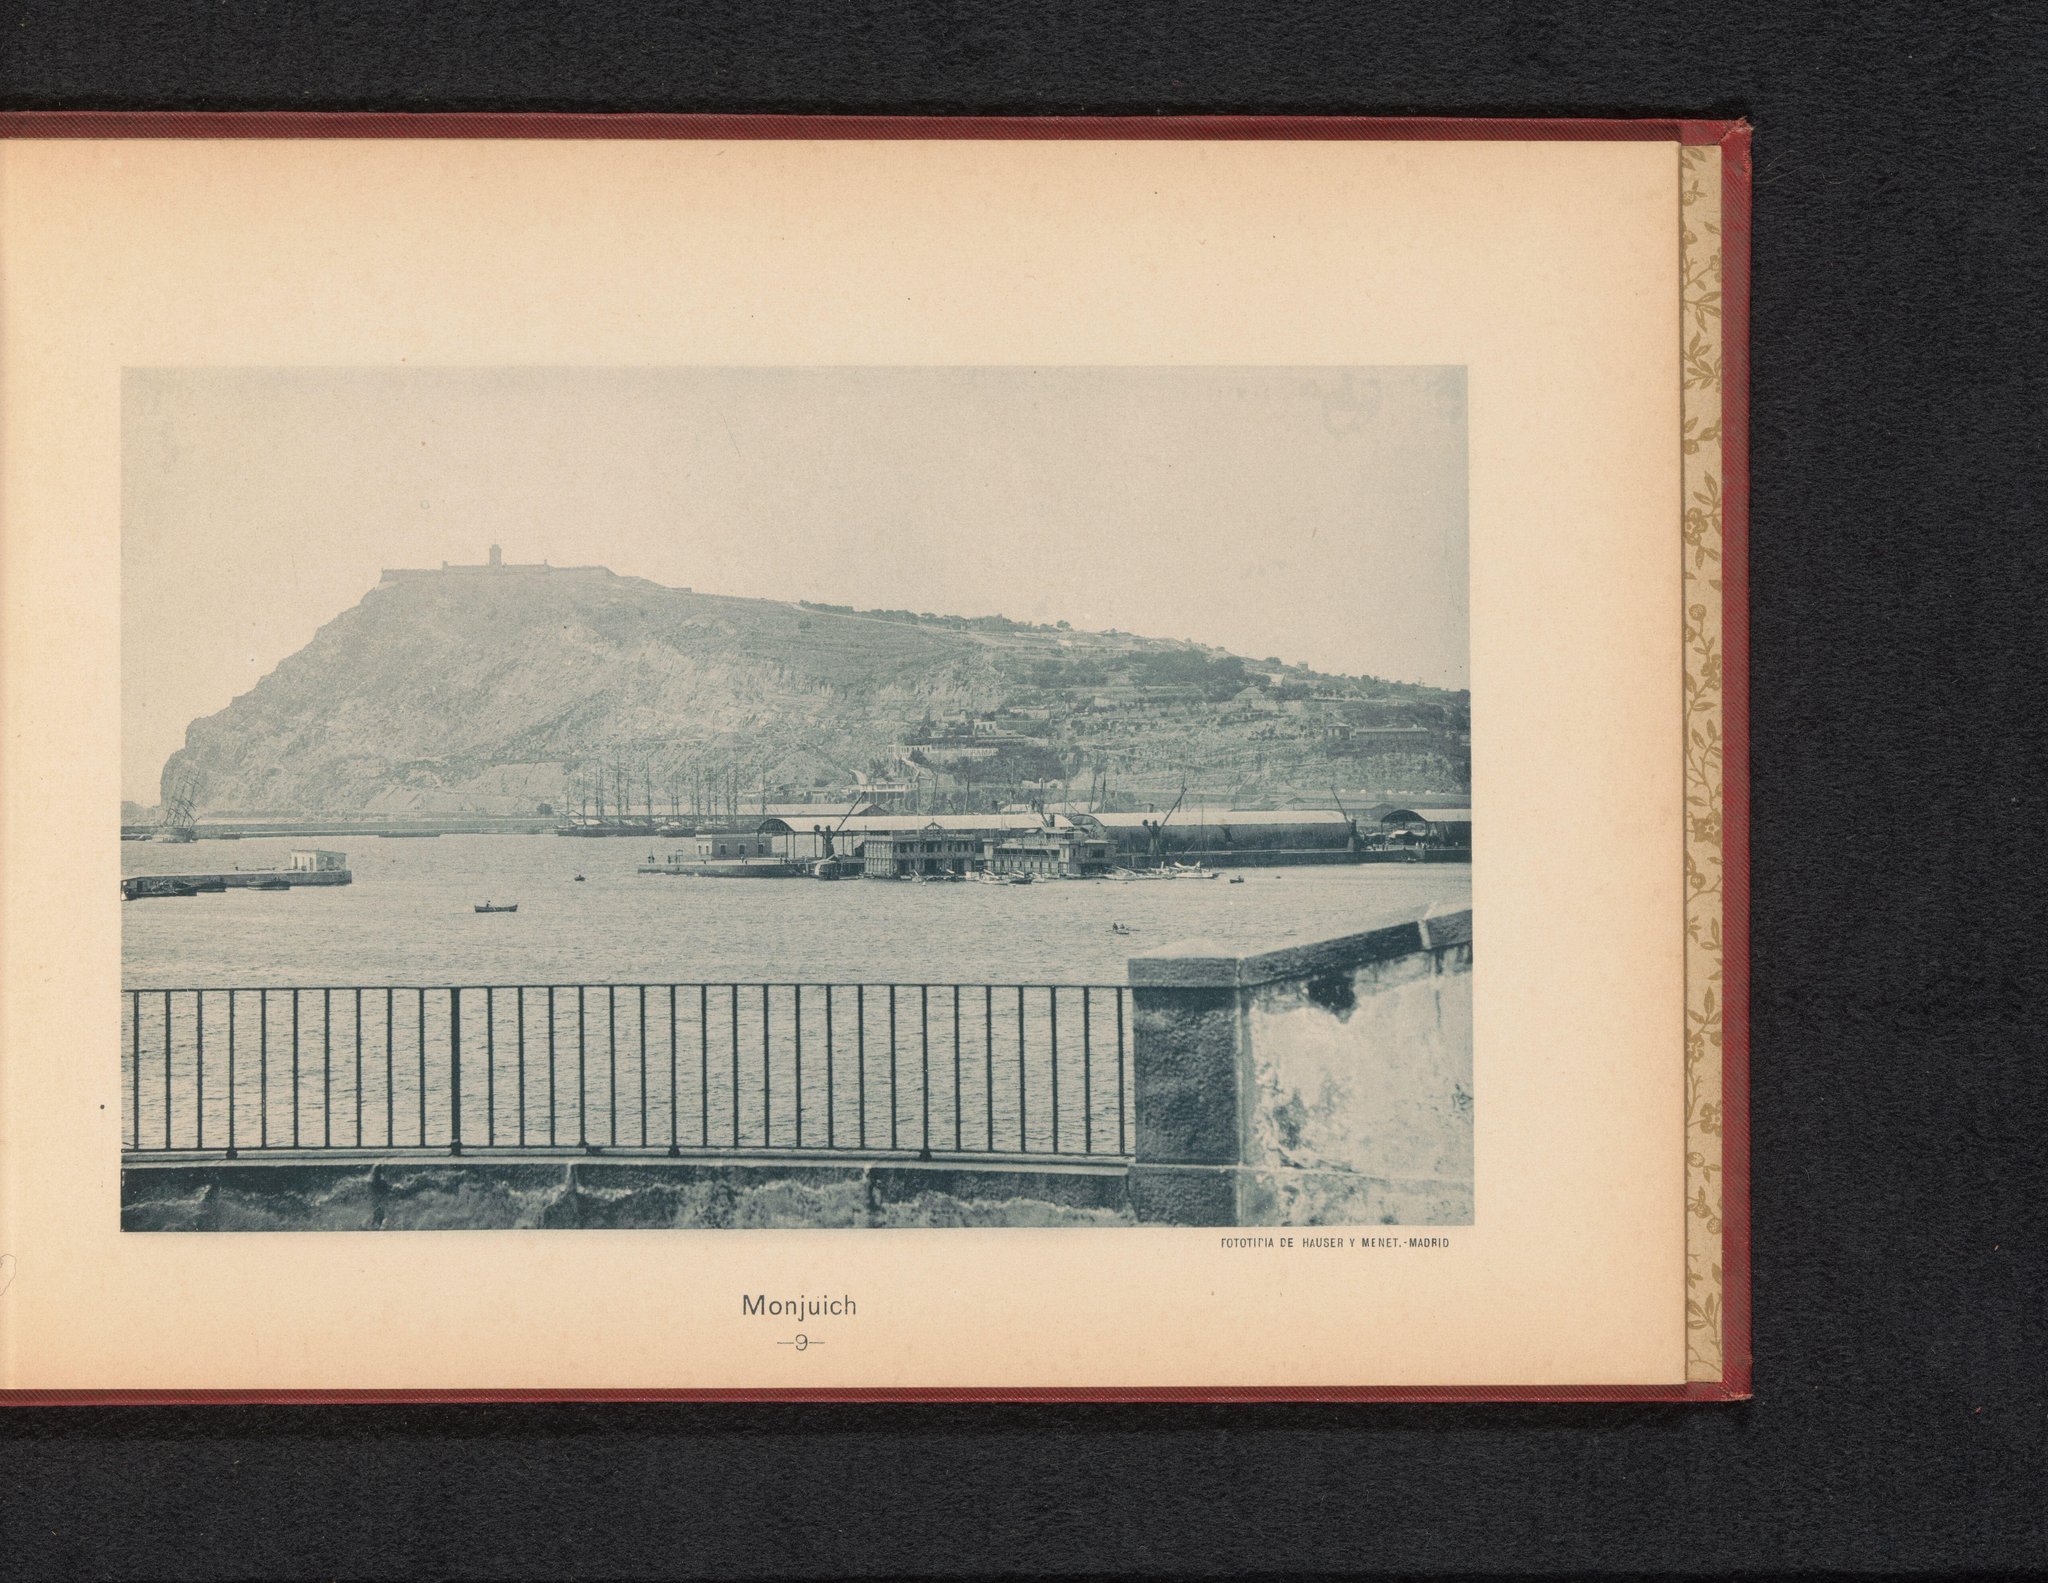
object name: page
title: Gezicht over het water op het kasteel van Montjuïc in Barcelona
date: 1880-1890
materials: paper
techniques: photograph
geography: barcelona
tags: harbour, castle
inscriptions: number: ‘-9-’